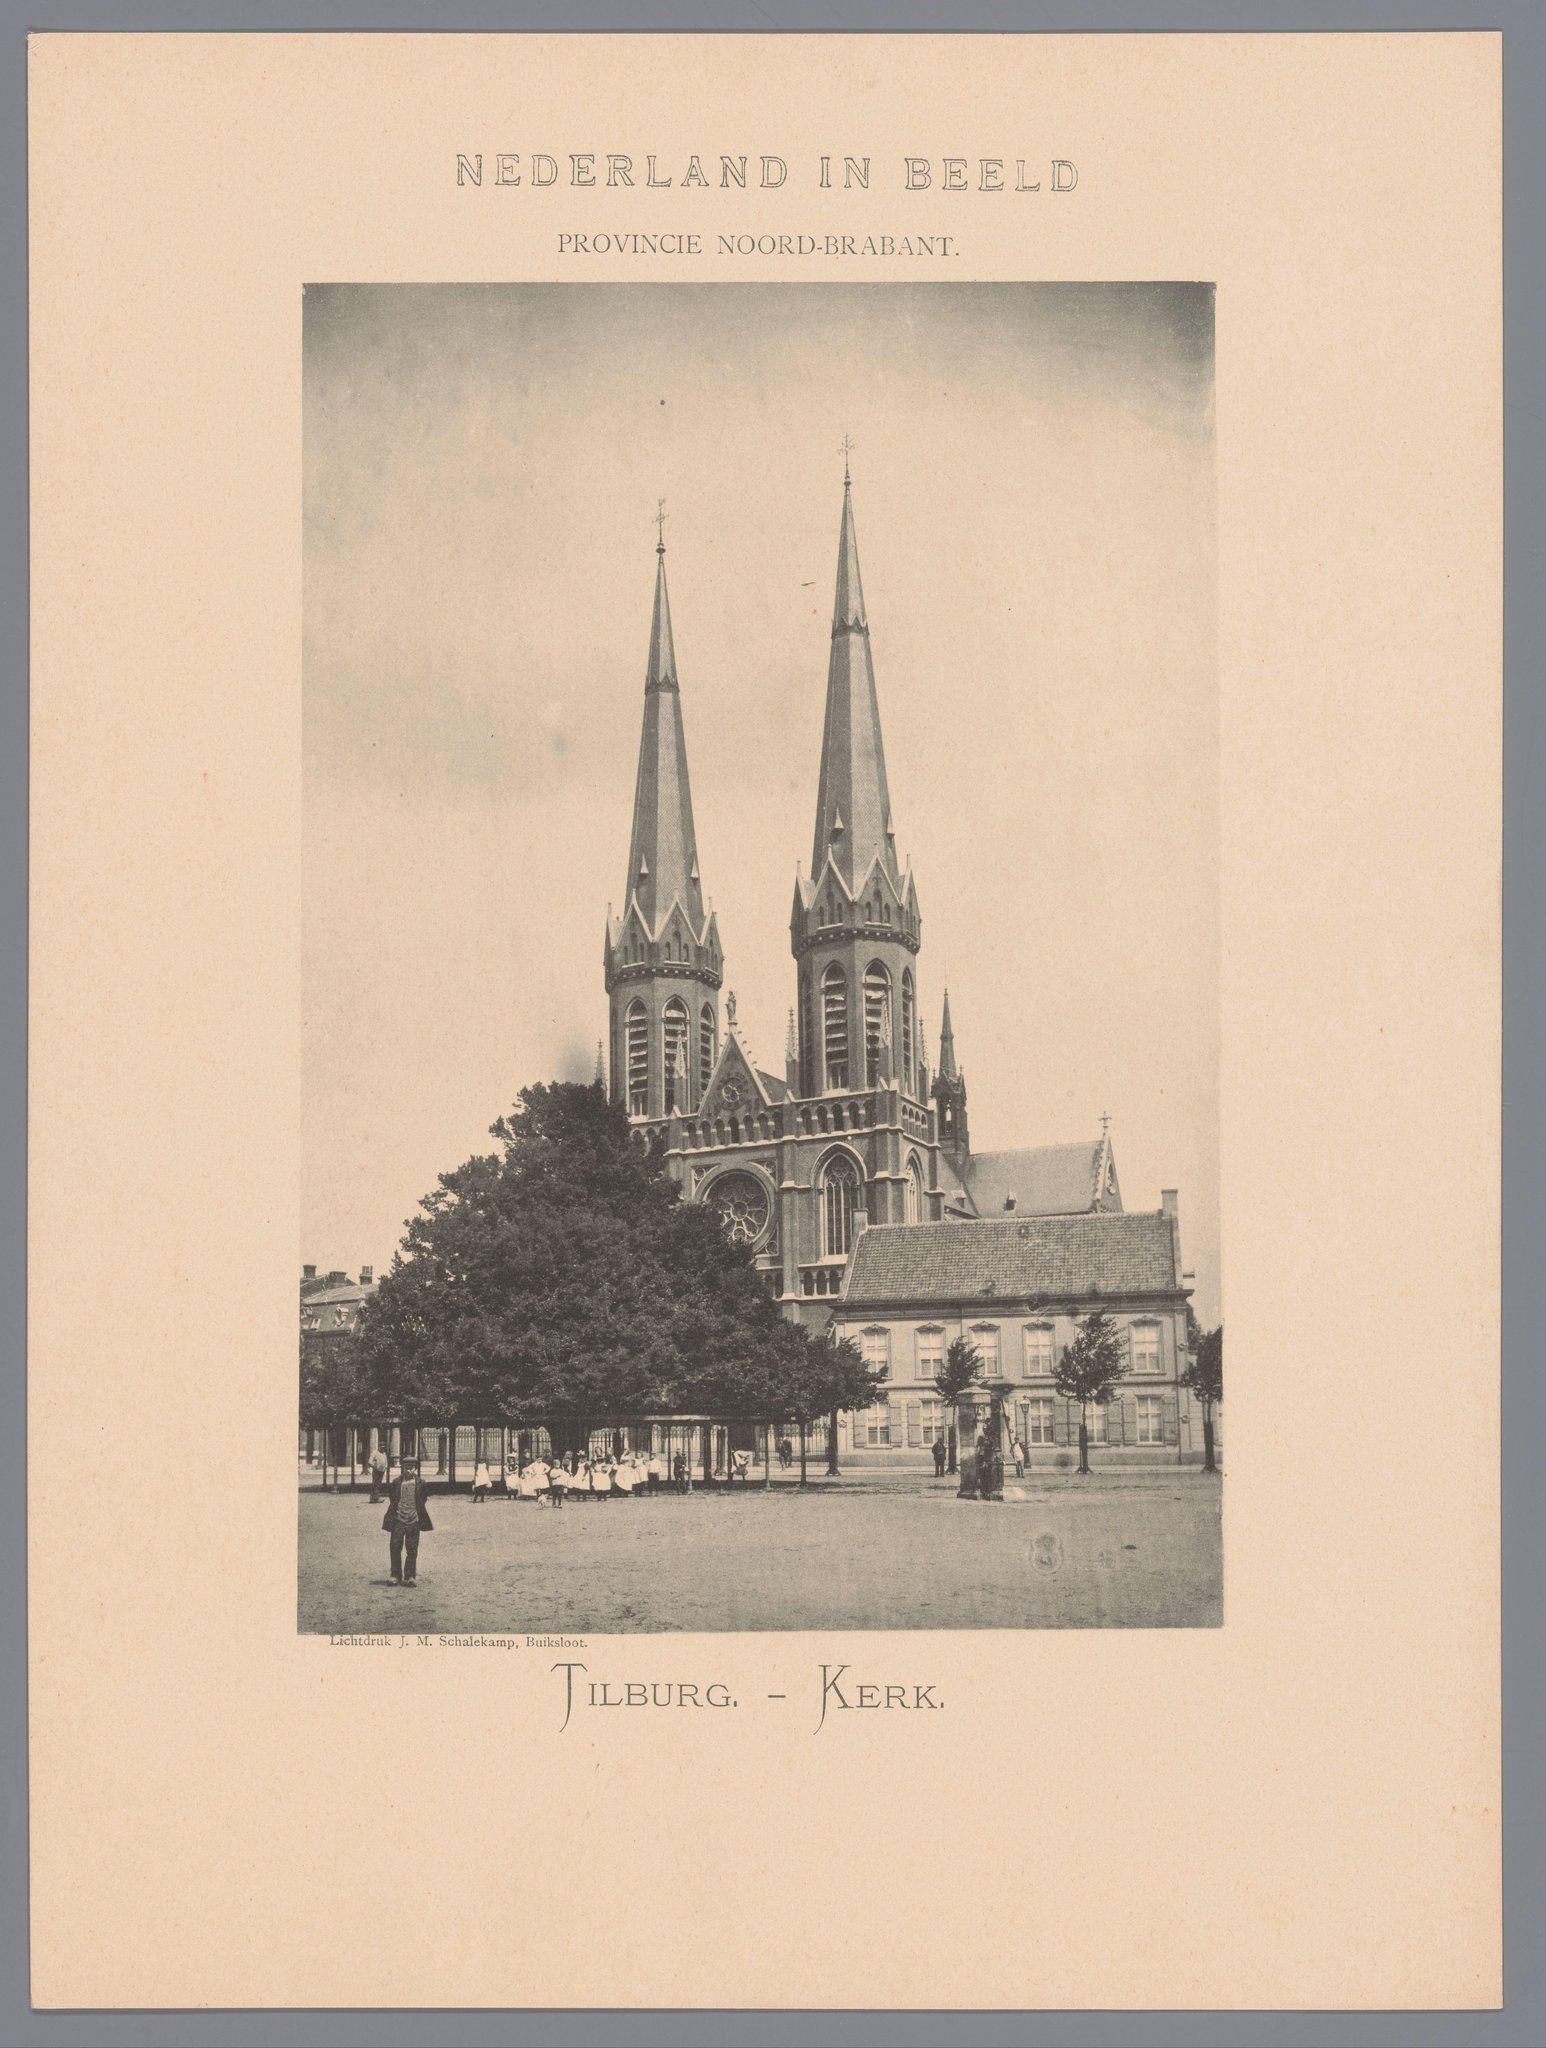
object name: photomechanical print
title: Gezicht op de Heuvelsekerk of Sint-Jozefkerk in Tilburg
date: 1875-1930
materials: paper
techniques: photograph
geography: buiksloot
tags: church (exterior)